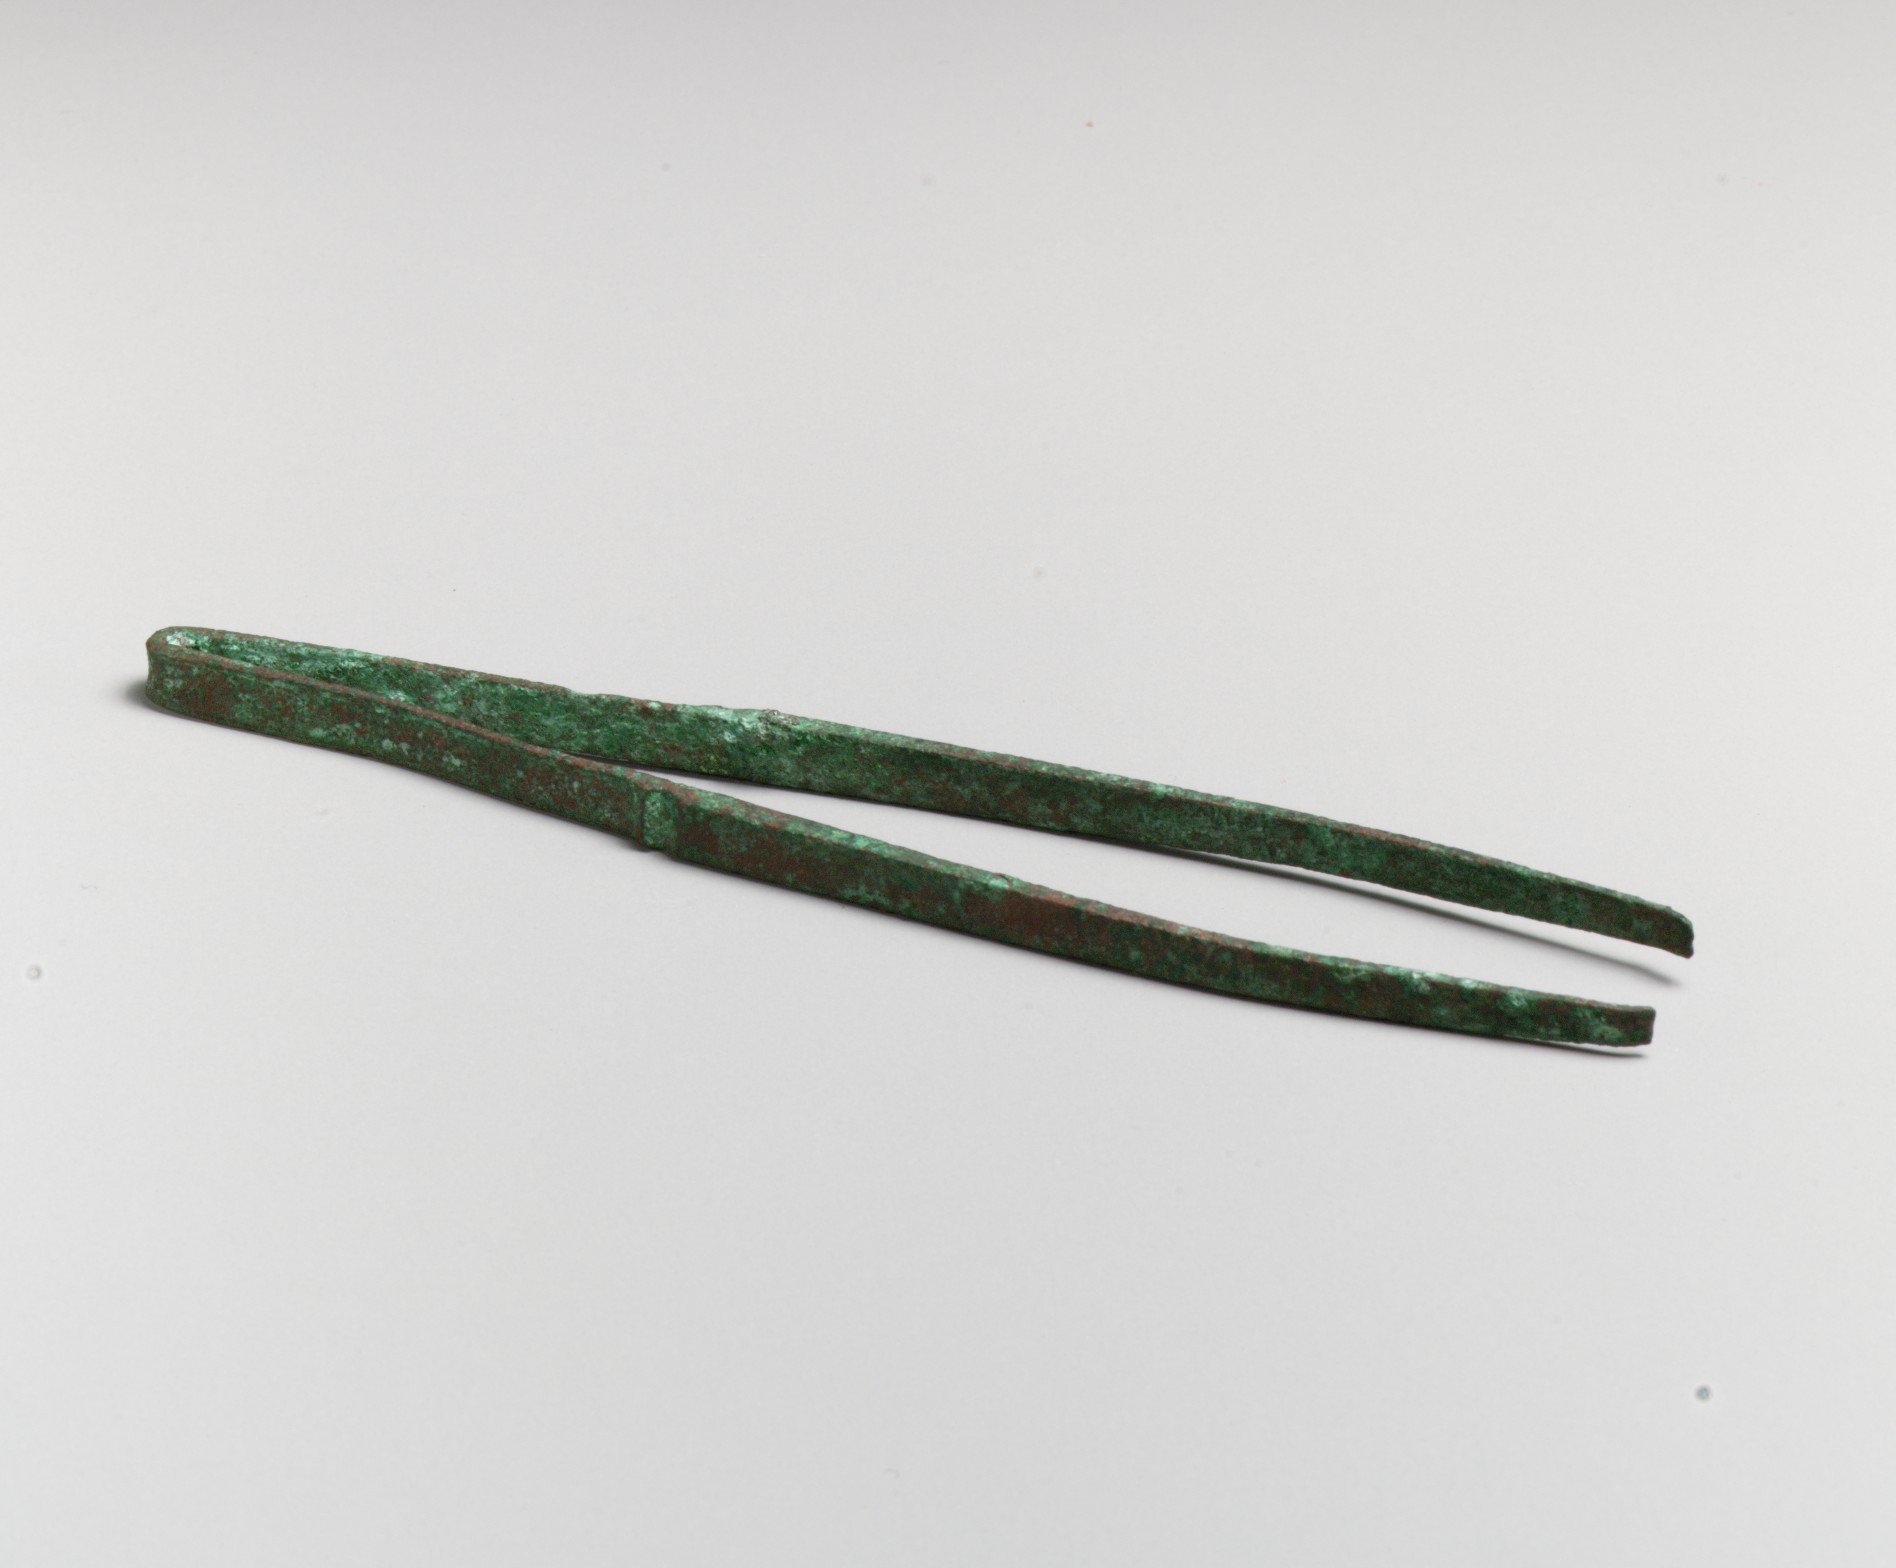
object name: tweezer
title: Tweezers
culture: roman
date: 670 BCE-330 CE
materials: bronze